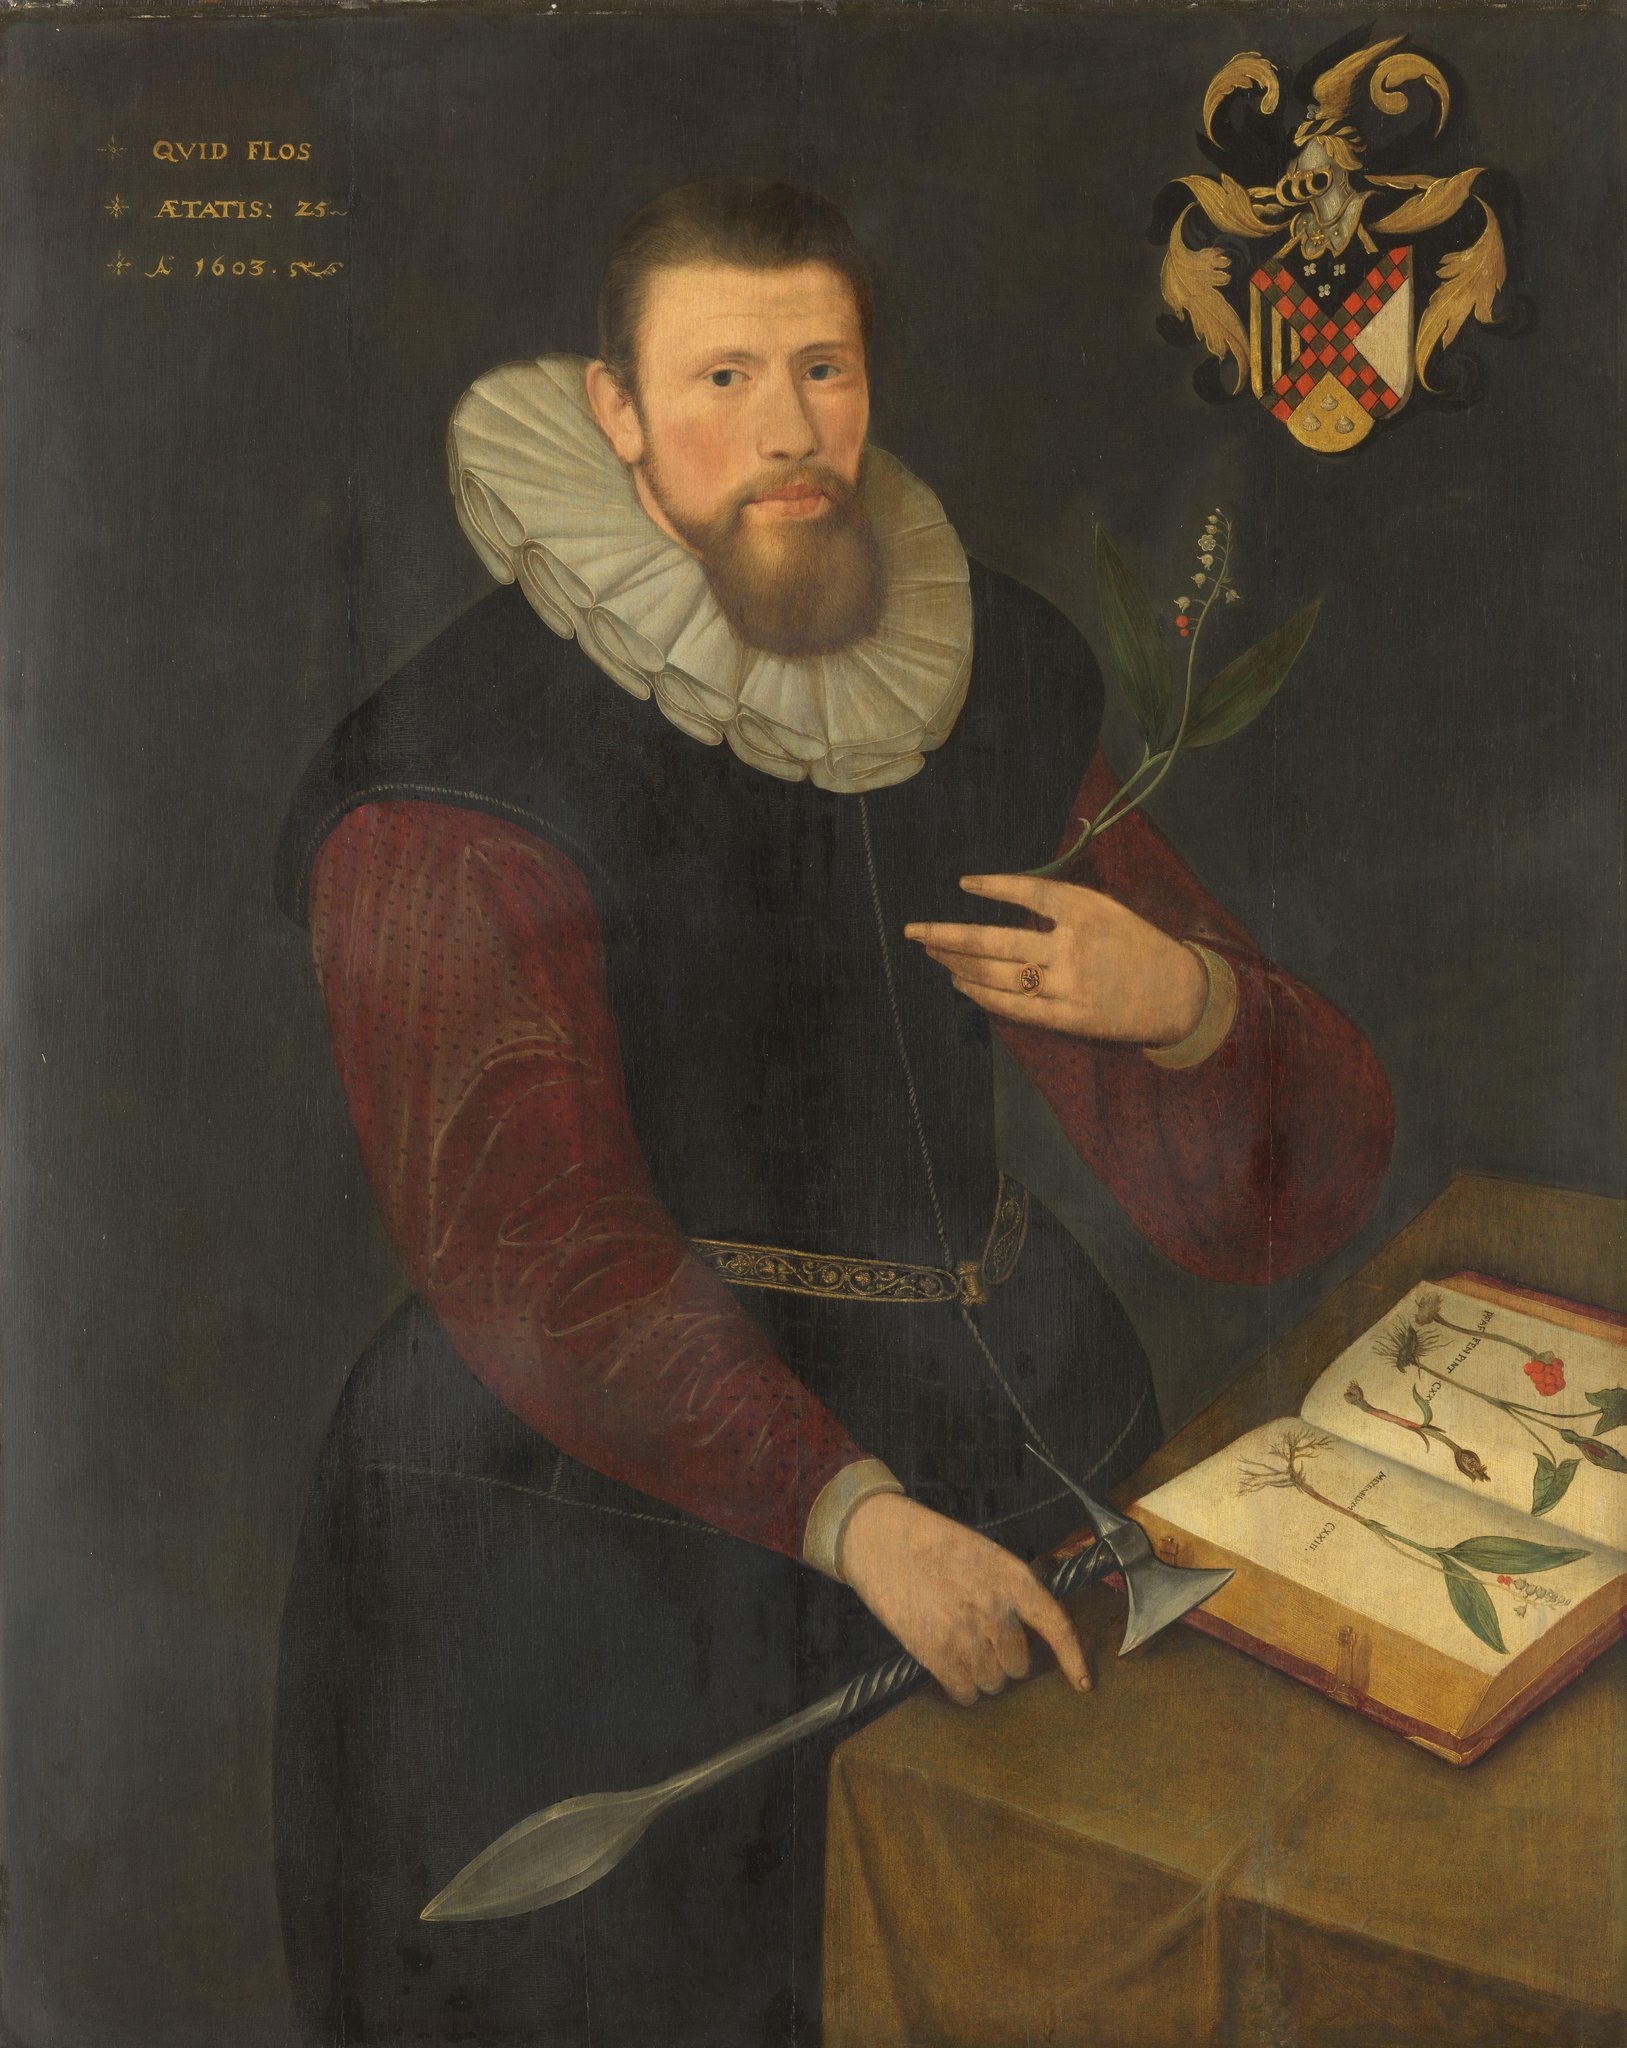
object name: painting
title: Portrait of a Botanist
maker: Anonymous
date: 1603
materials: oil, panel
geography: germany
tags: flowers: lily of the valley, scholar, philosopher, book in which illustrations are essential - mm - book open, botany (+ scholar, scientist (at work)), armorial bearing, heraldry, historical persons not known by name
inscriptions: inscription and date: ‘* Quid Flos * AEtatis 25 * Aº 1603.’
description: Portret van een botanicus. Portret van een man, ten halven lijve, staande achter een tafel waarop een boek met afbeeldingen van planten ligt. In de linkerhand een lelietje-van-dalen, in de rechterhand een strijdbijl. Rechtsboven het familiewapen. Pendant van SK-A-969.